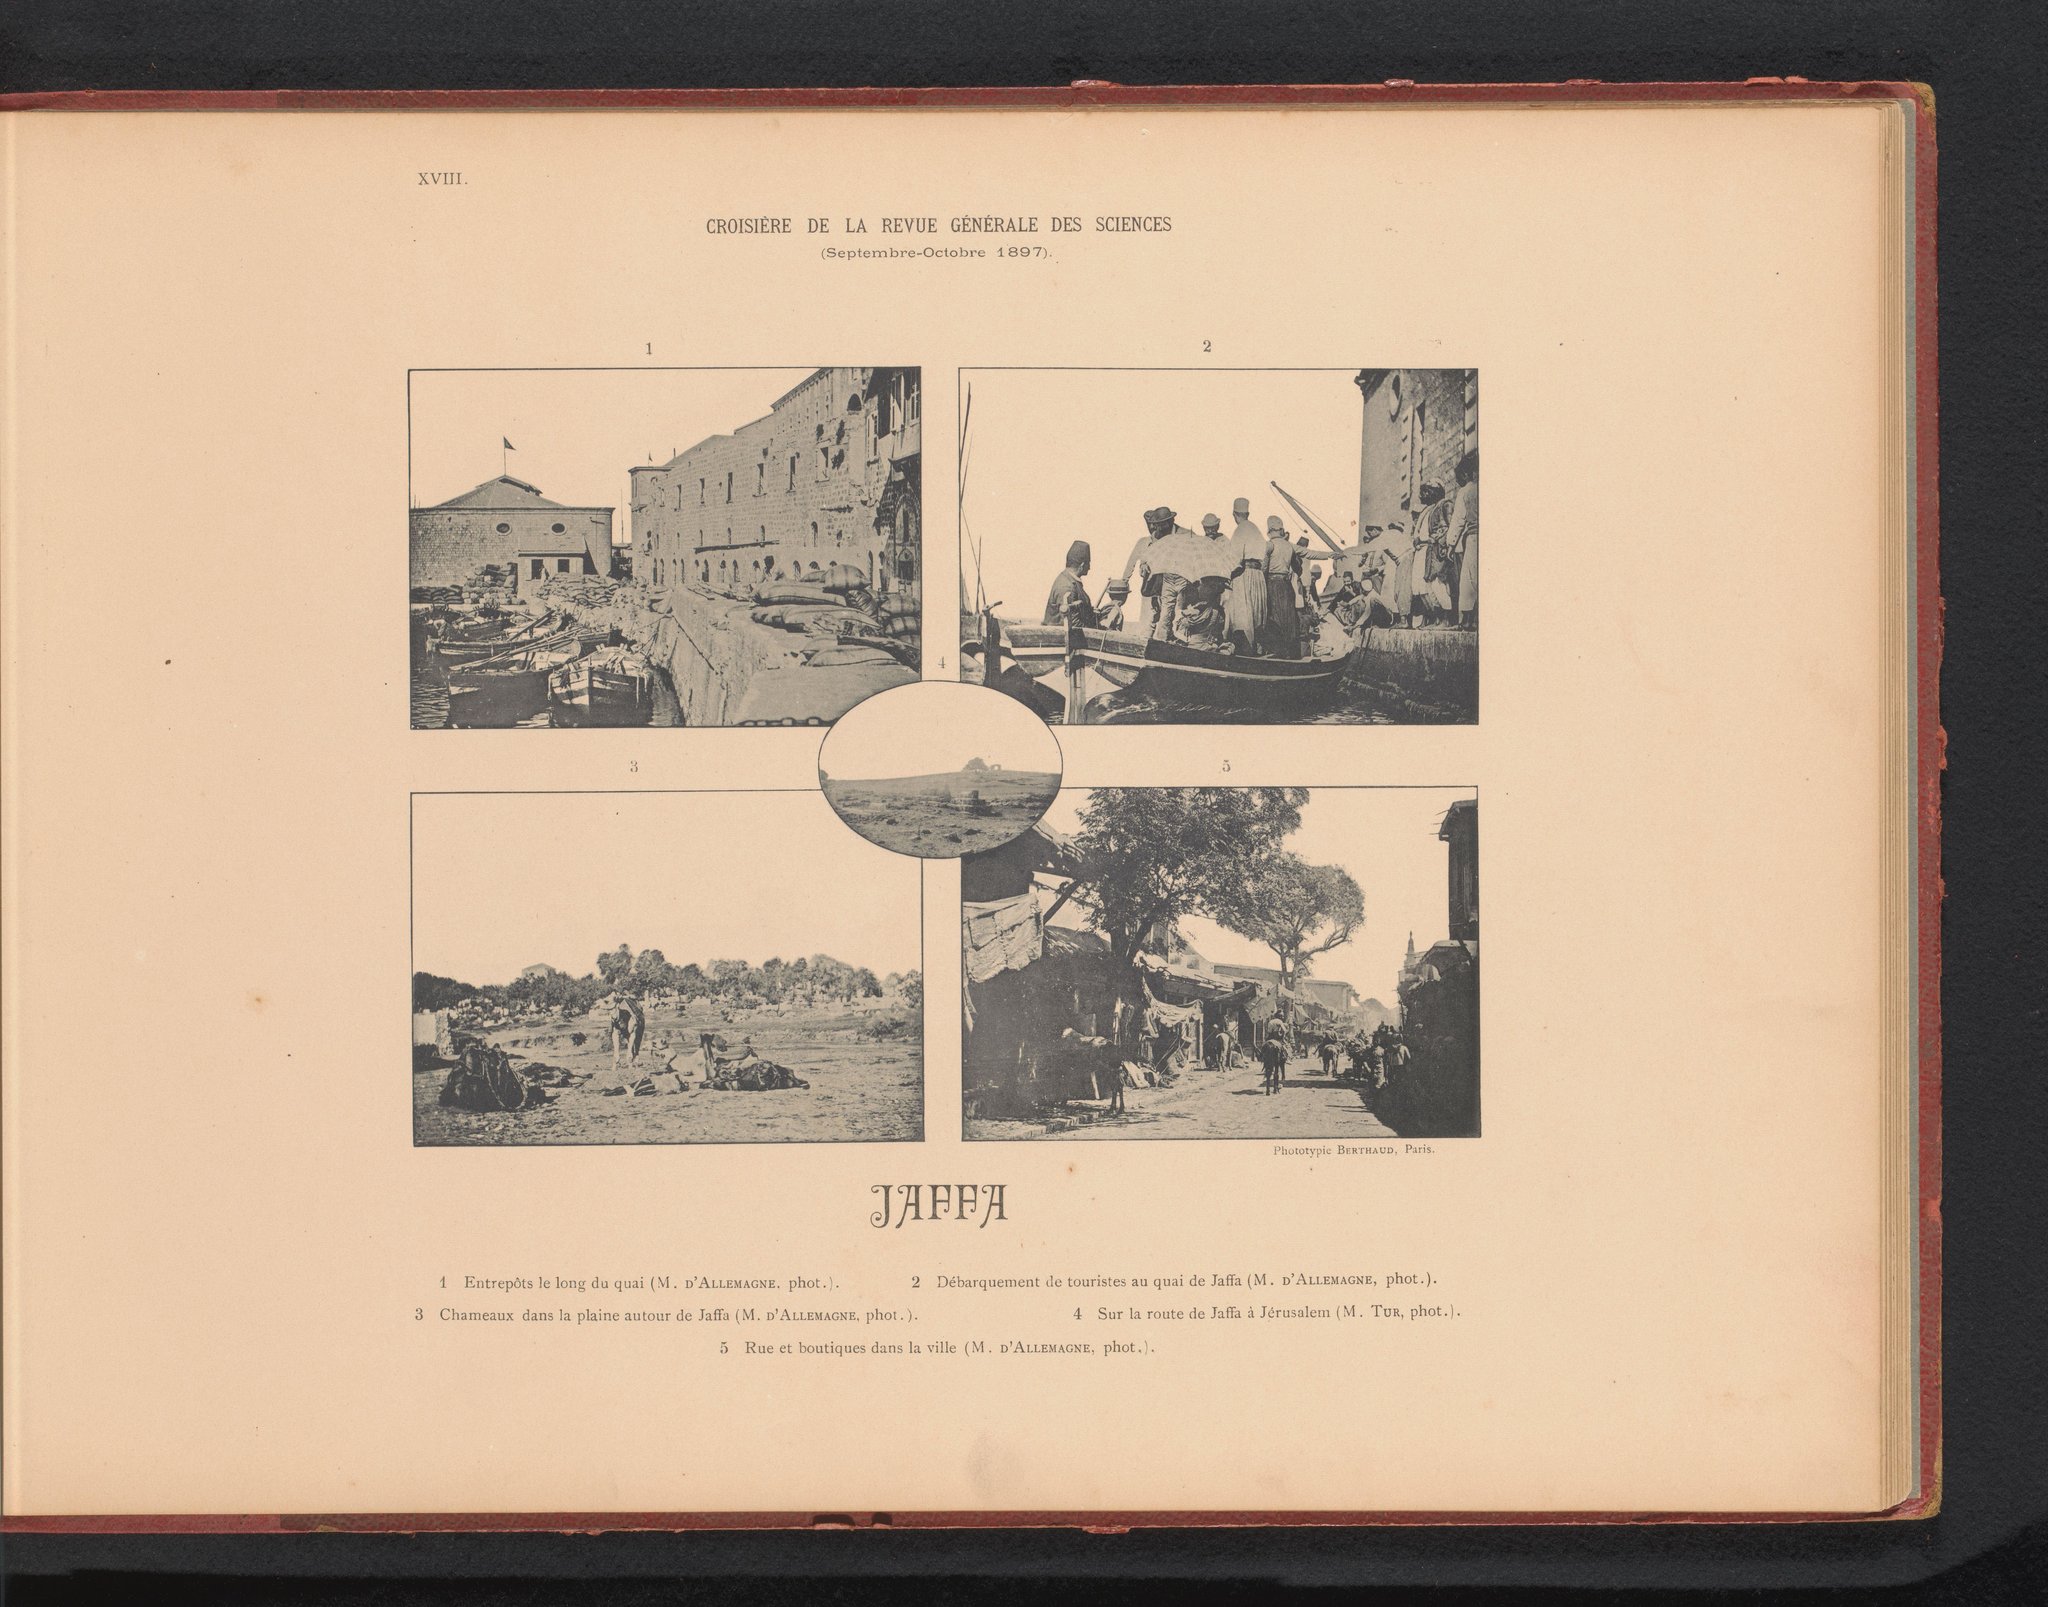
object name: page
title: Vijf gezichten op Jaffa, Israël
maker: michel berthaud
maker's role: publisher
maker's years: 1845-1912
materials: paper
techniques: photograph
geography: paris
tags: city-view in general; 'veduta', street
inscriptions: inscription: ‘1 Entrepôts le long du quai (M. d'Allemagne, phot.). 2 Débarquement de touristes au quai de Jaffa (M. d'Allemagne, phot.)./ 3 Chameaux dans la plaine autour de Jaffa (M. d'Allemagne, phot.). 4 Sur la route de Jaffa à Jérusalem (M. Tur, phot.)./ 5 Rue et boutiques dans la ville (M. d'Allemagne, phot.).’, number: ‘XVIII.’